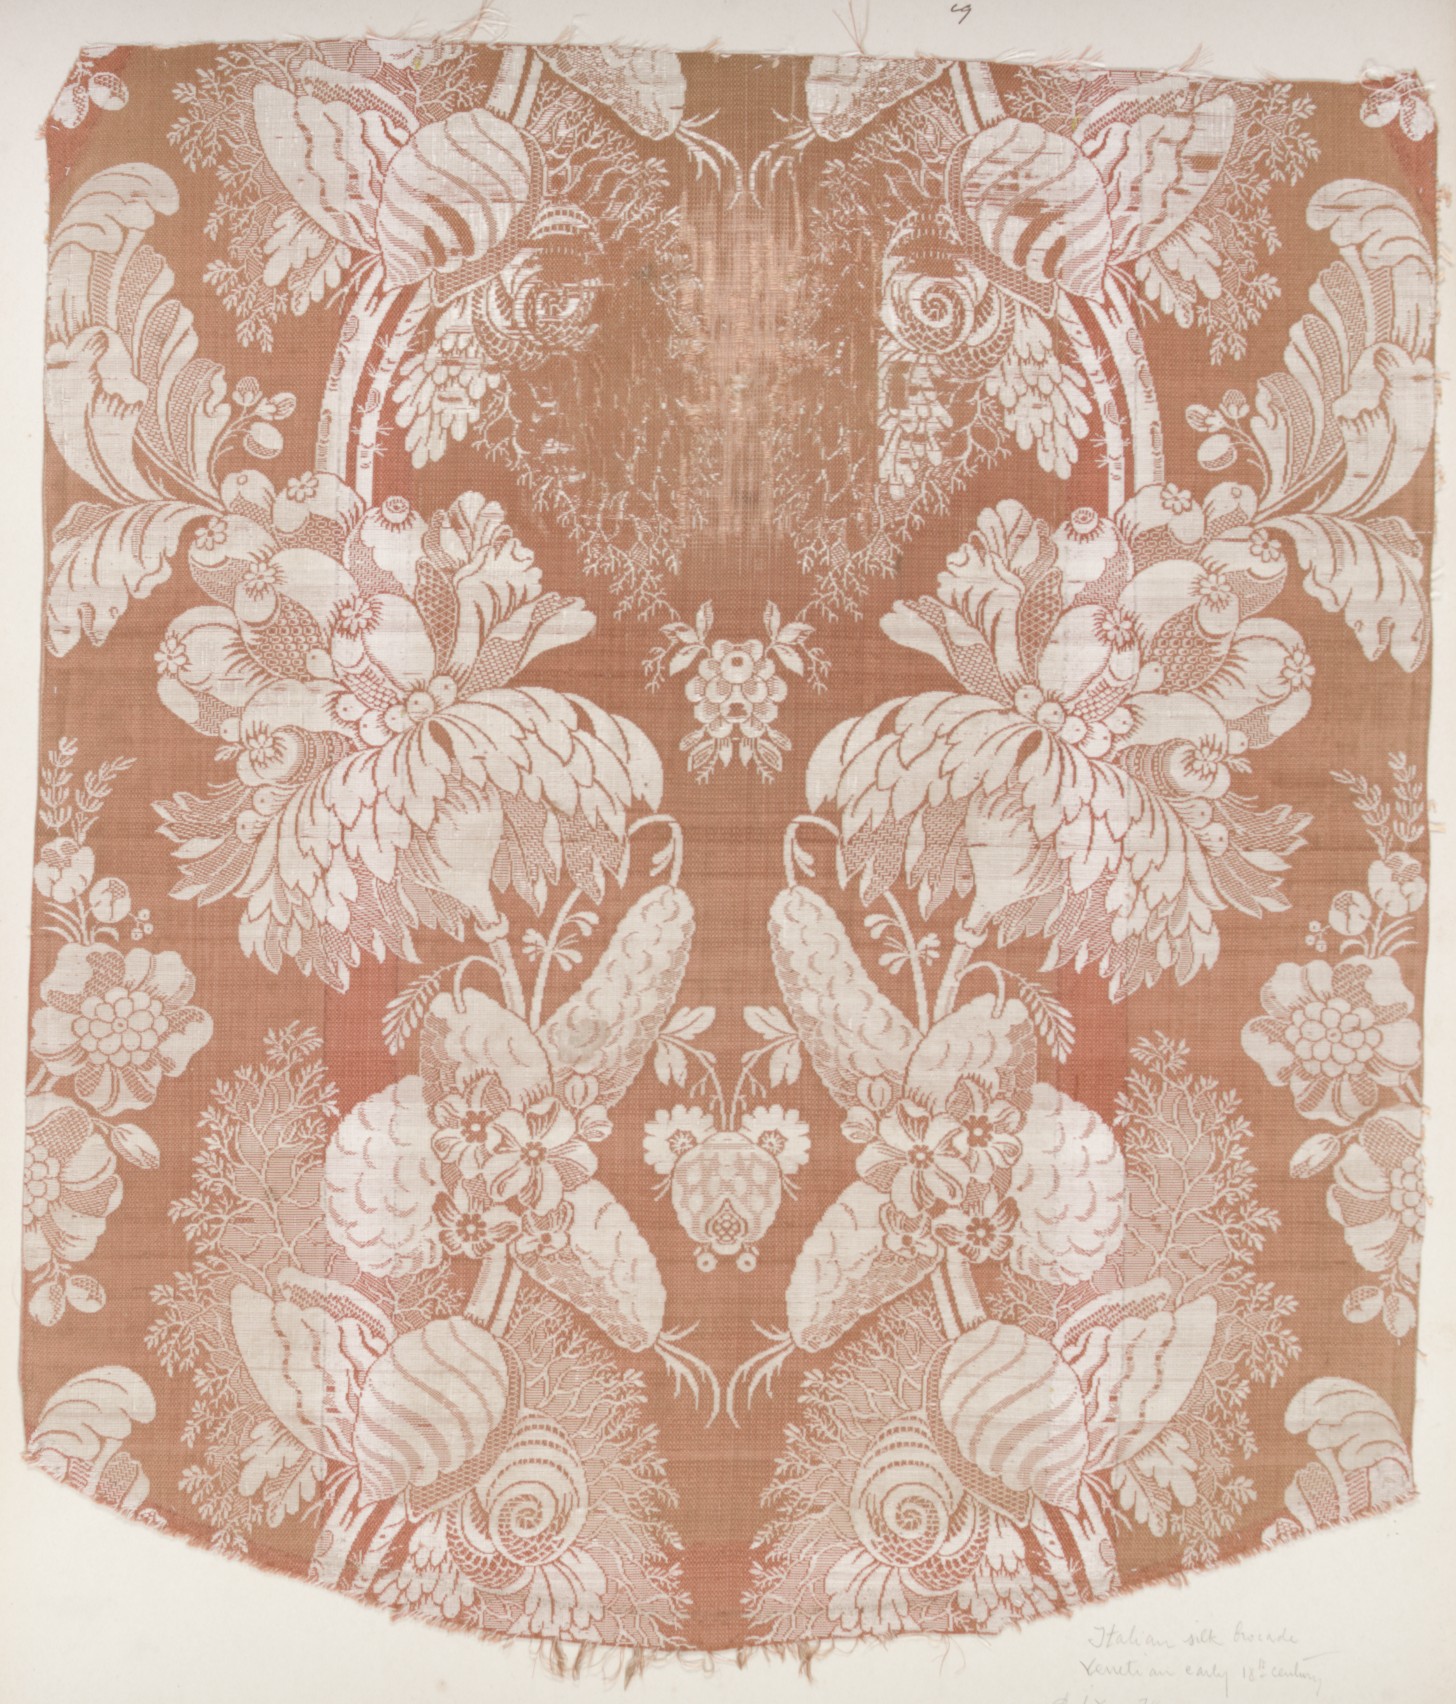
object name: fragment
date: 1701-1750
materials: silk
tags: flowers,leaves